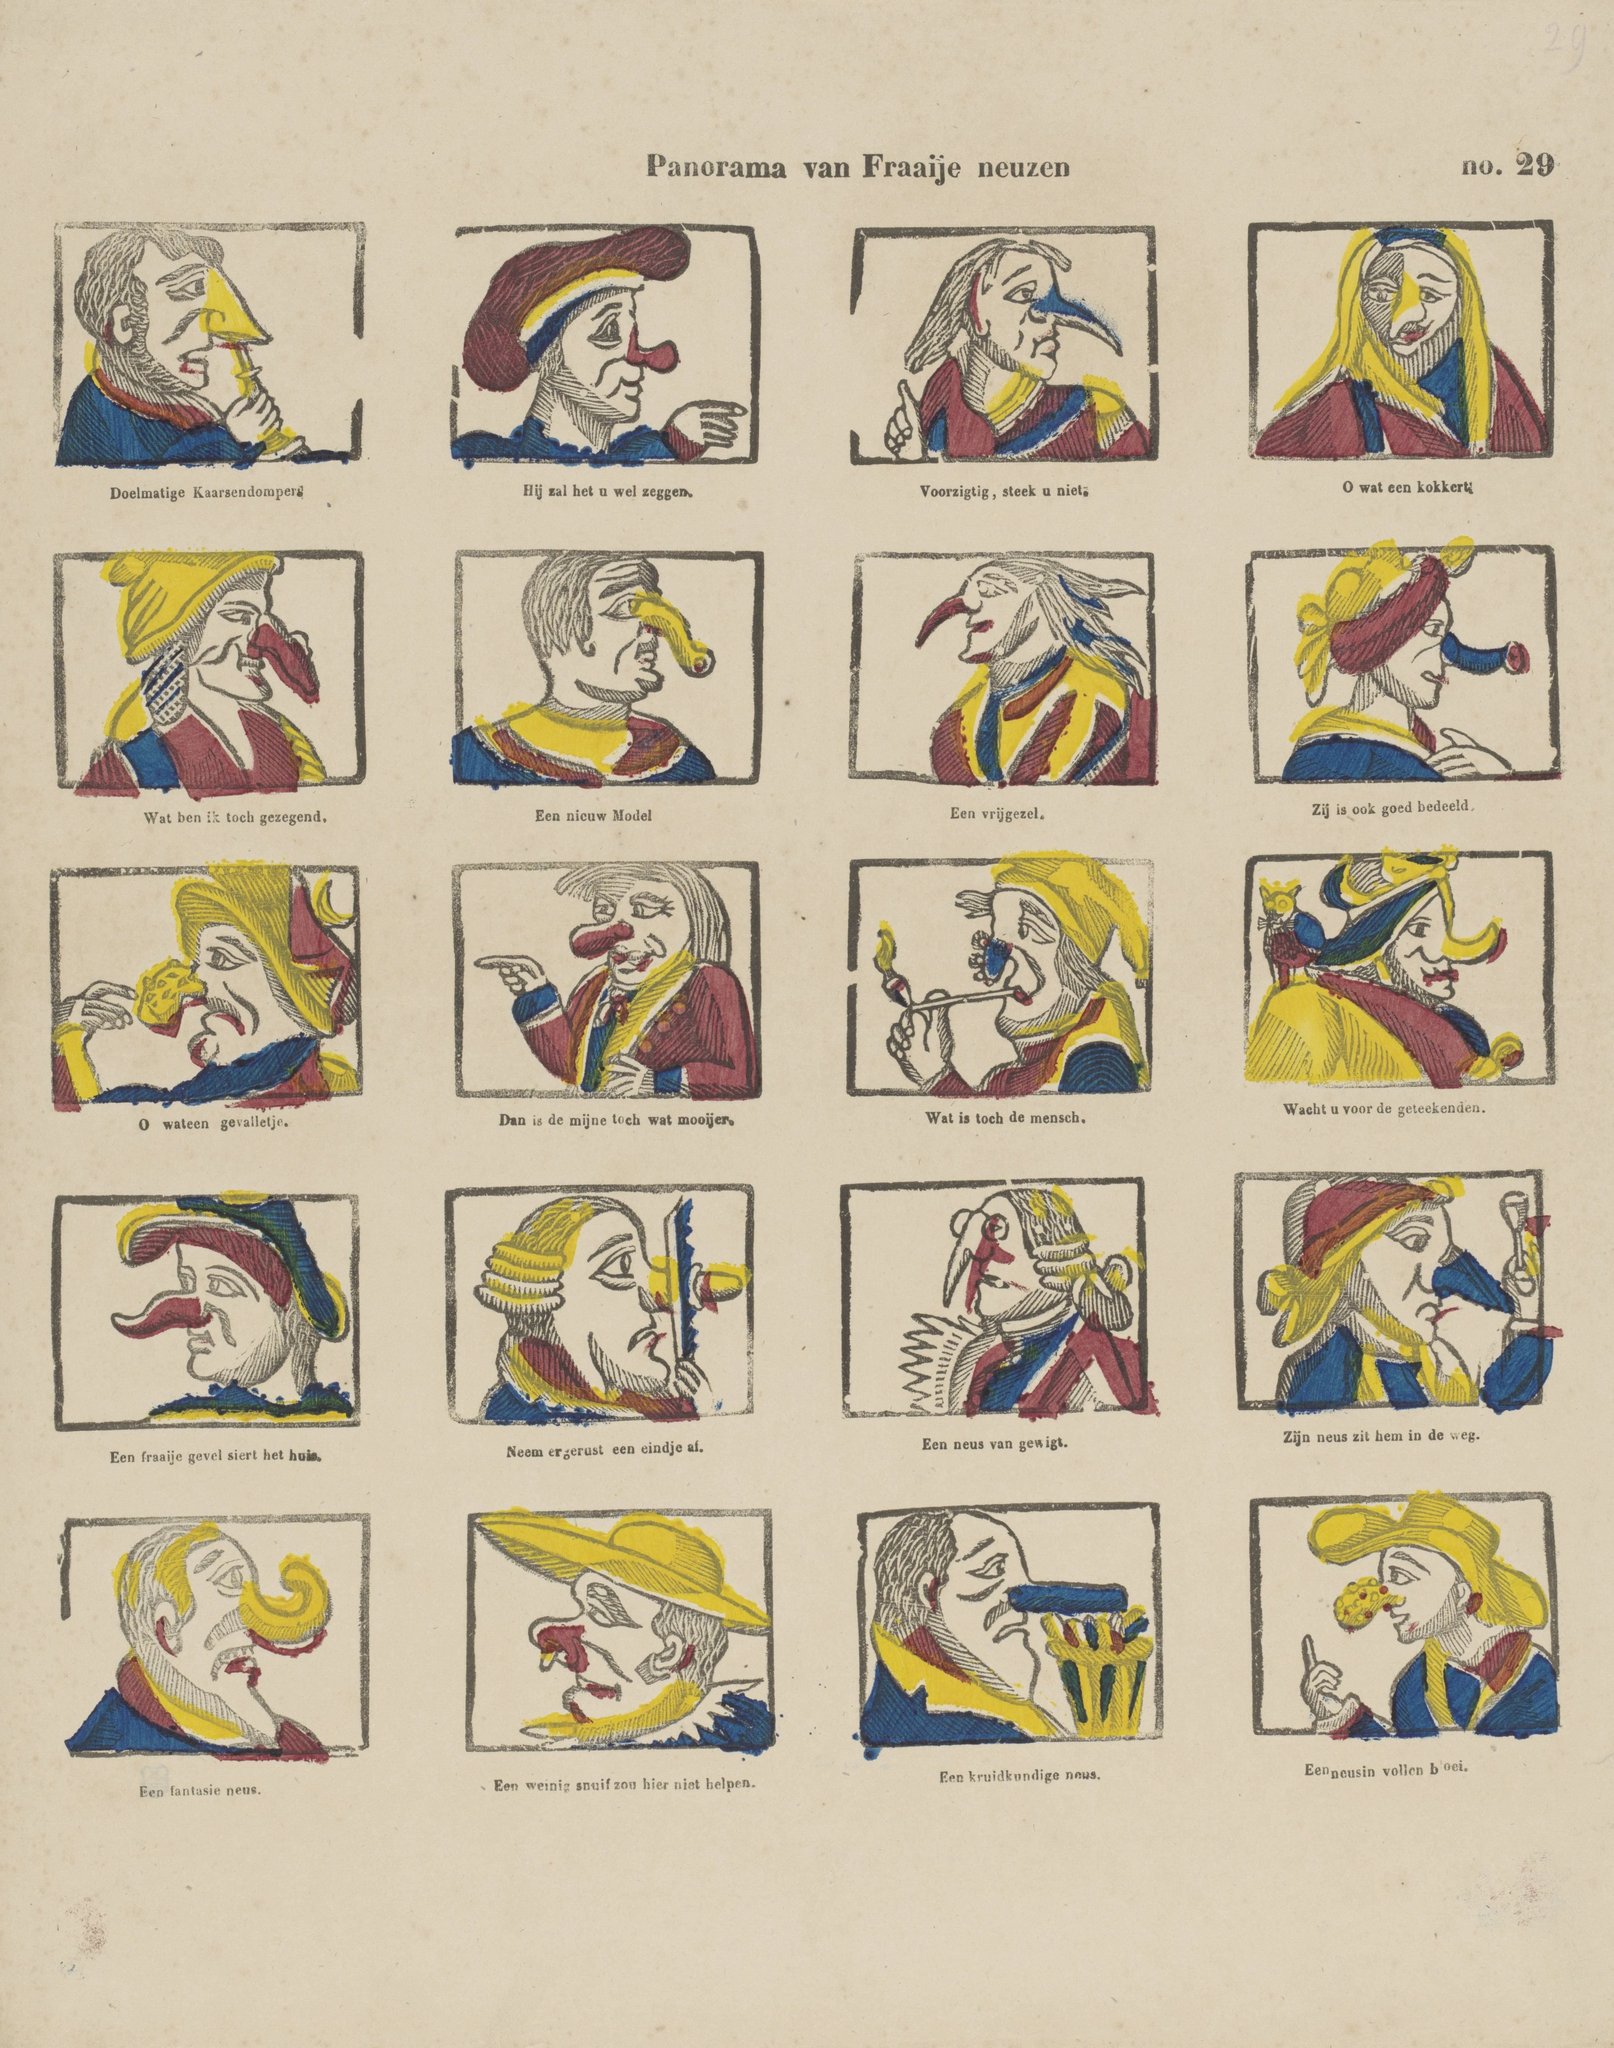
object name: popular print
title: Panorama van fraaije neuzen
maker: Anonymous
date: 1848-1881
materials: paper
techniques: colour, letterpress printing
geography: netherlands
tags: caricatures (human types), parts of the face: nose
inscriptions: collector's mark: Lugt 2760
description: Blad met 20 komische voorstellingen van figuren met grote en misvormde neuzen. Onder elke afbeelding een onderschrift. Genummerd rechtsboven: no. 29.